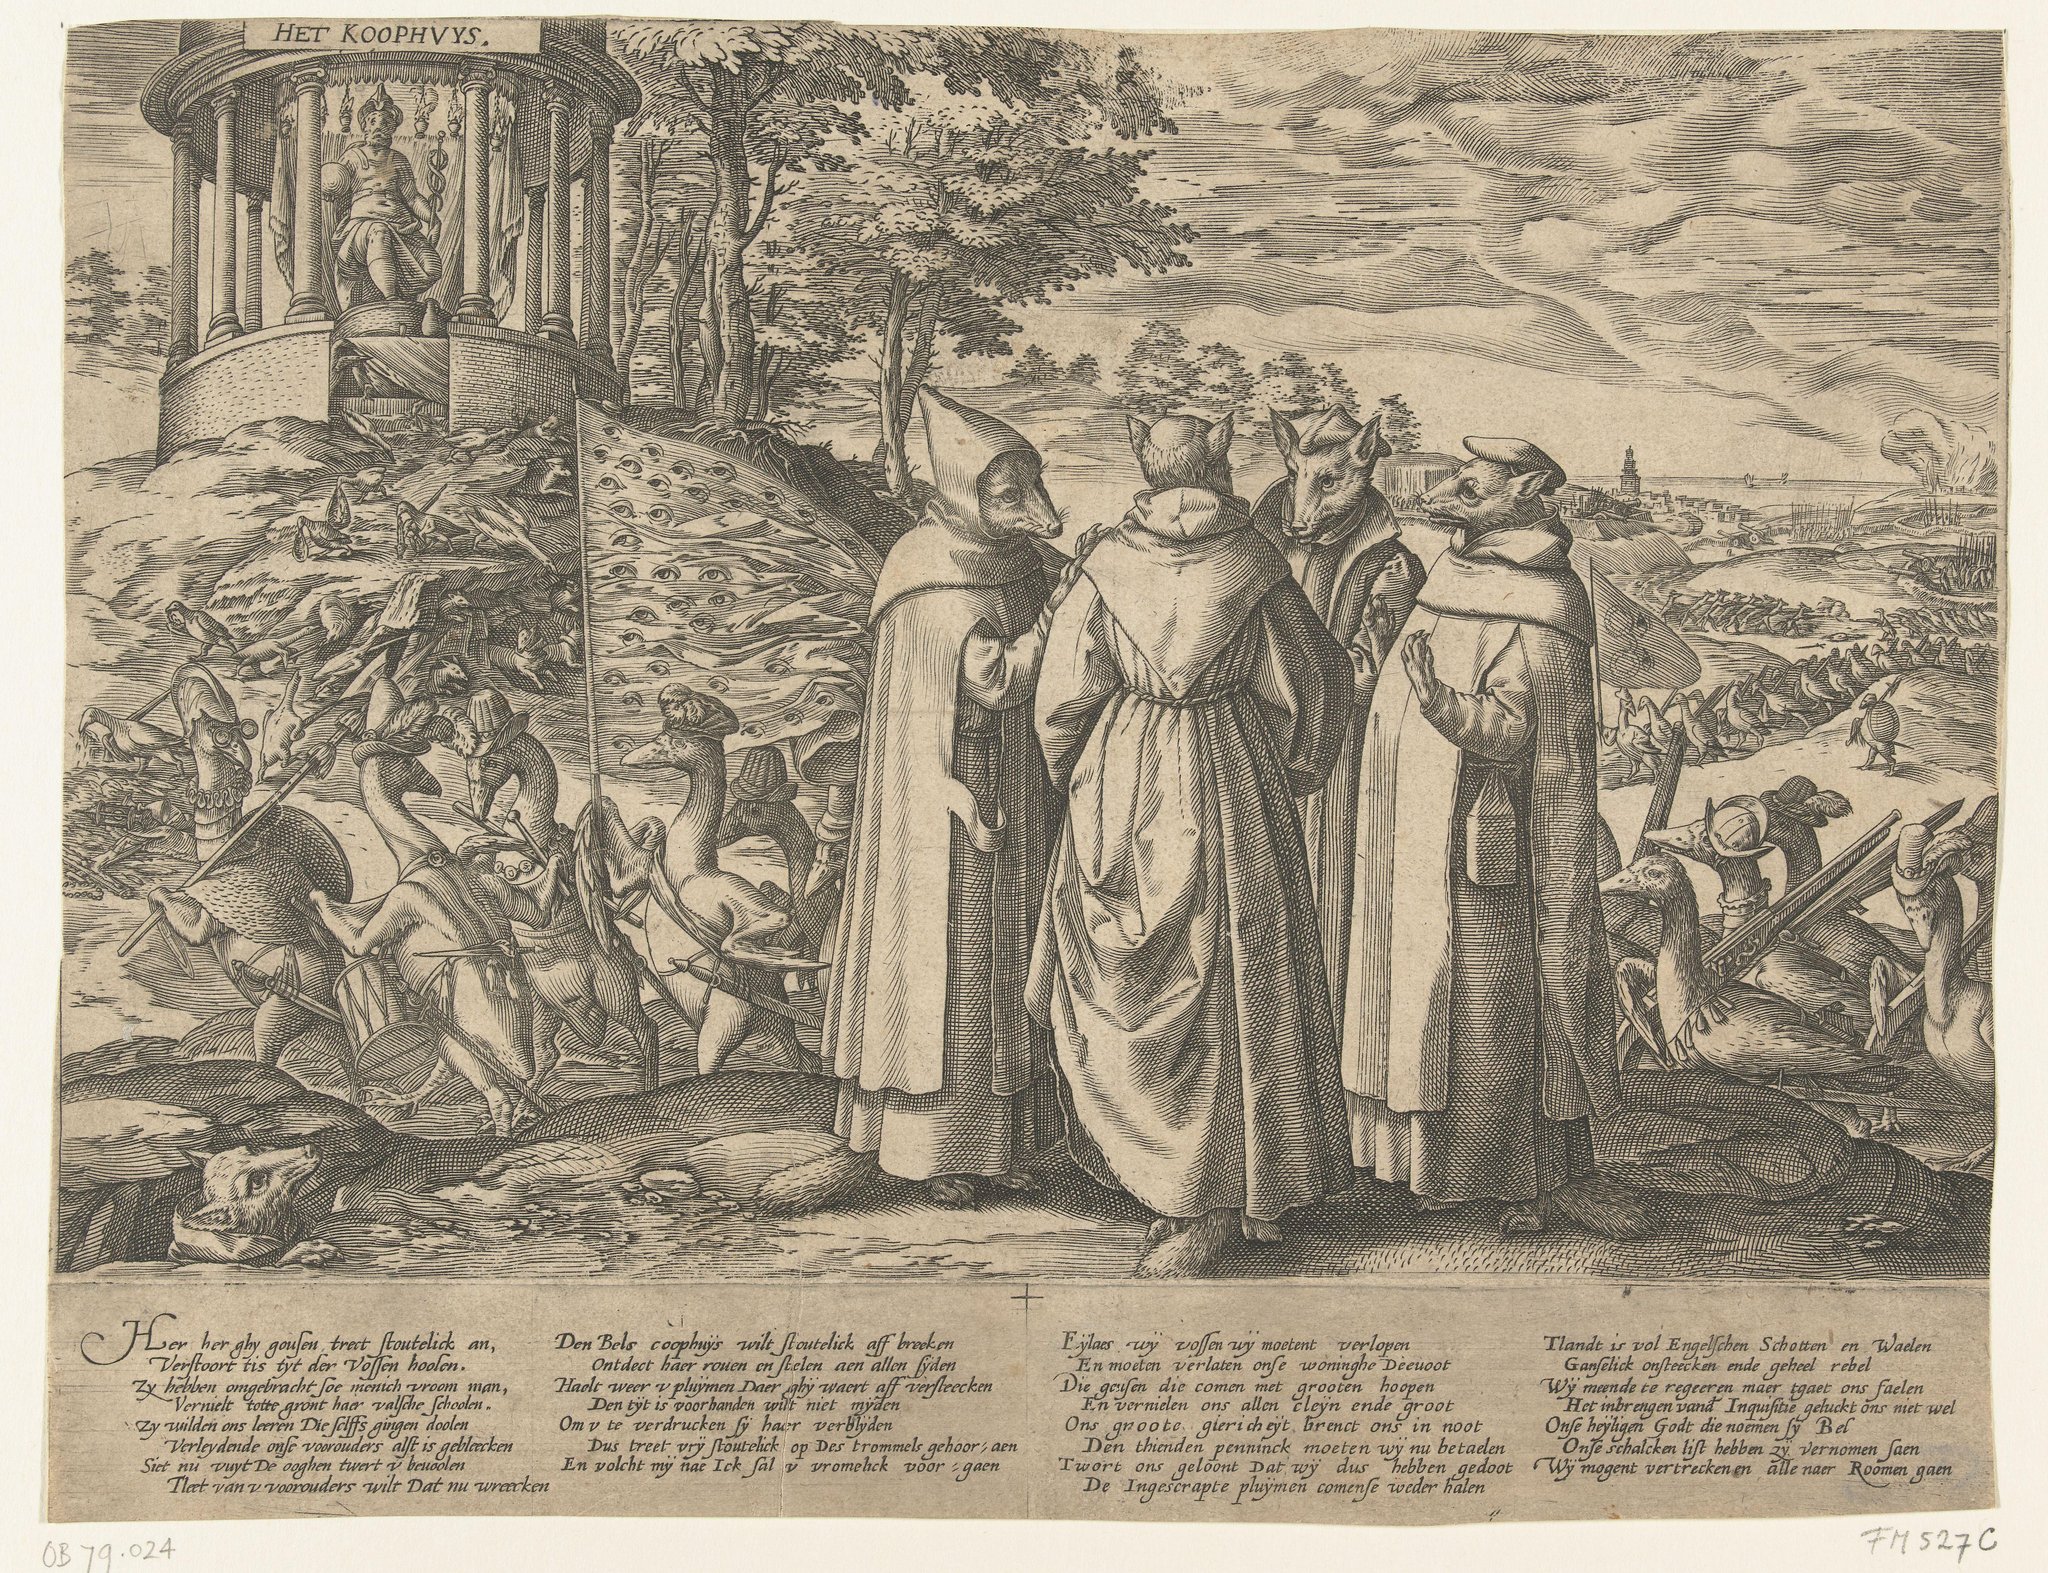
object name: cartoon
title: De ganzen verjagen de vossen, ca. 1572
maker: Anonymous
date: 1572-1573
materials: paper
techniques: engraving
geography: northern netherlands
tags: animals acting as human beings, the roman catholic church vs. protestantism; (reformation and counter reformation)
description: Spotprent op de verslechterde positie van de Roomse kerk in Nederland. Vossen in kleding van priesters en monniken maken zich zorgen over hun positie nu de ganzen aan het winnen zijn. Op de voorgrond vier vossen met elkaar in gesprek. Hierachter trekt een lange stoet van soldaten als ganzen door het land. Linksboven de tempel ‘Het Koophuys’, gewijd aan geldzucht. In het onderschrift op een aparte plaat onder de voorstelling 4 verzen van afwisselend 8 en 7 regels in het Nederlands.